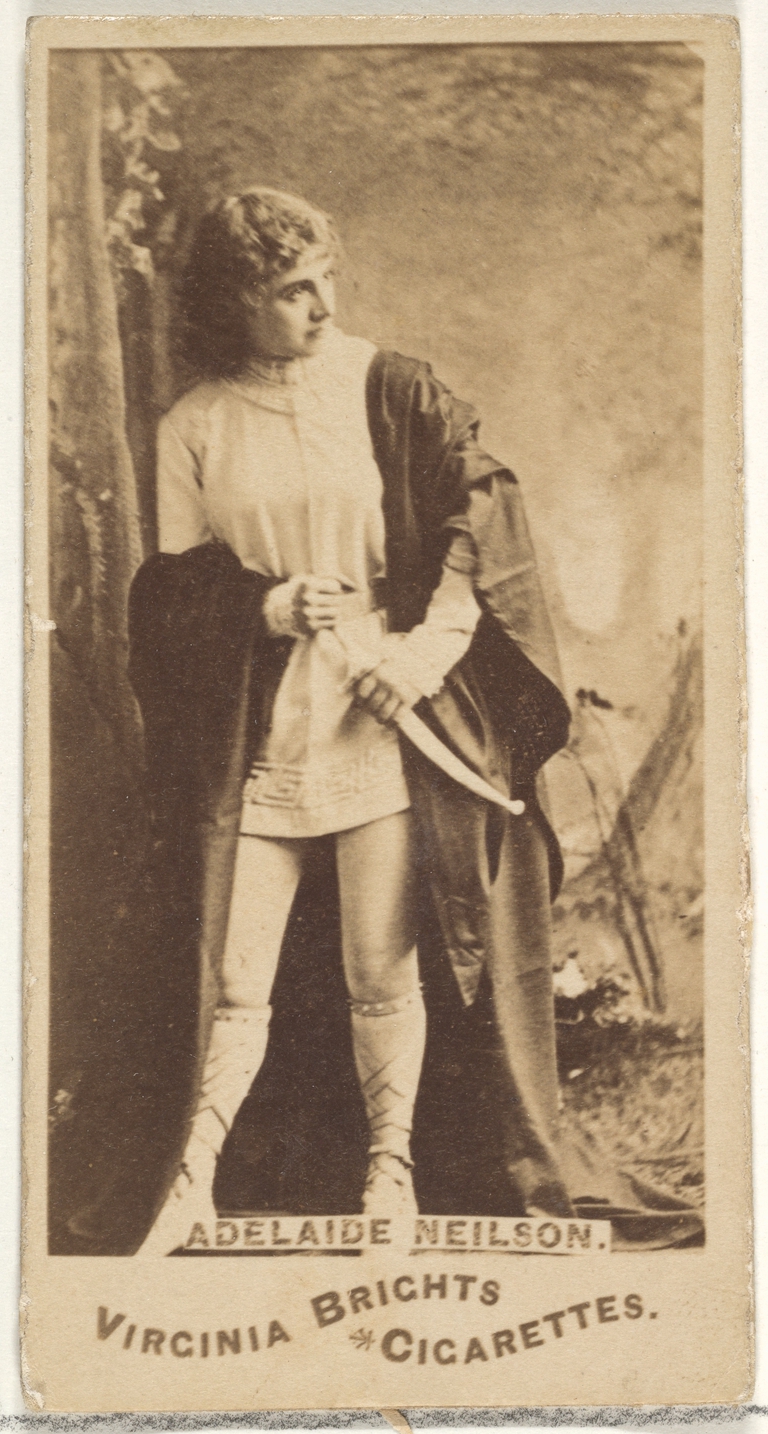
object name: photograph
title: Adelaide Neilson, from the Actors and Actresses series (N45, Type 1) for Virginia Brights Cigarettes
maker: allen & ginter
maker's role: publisher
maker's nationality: american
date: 1888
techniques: albumen silver print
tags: portraits,women,actresses